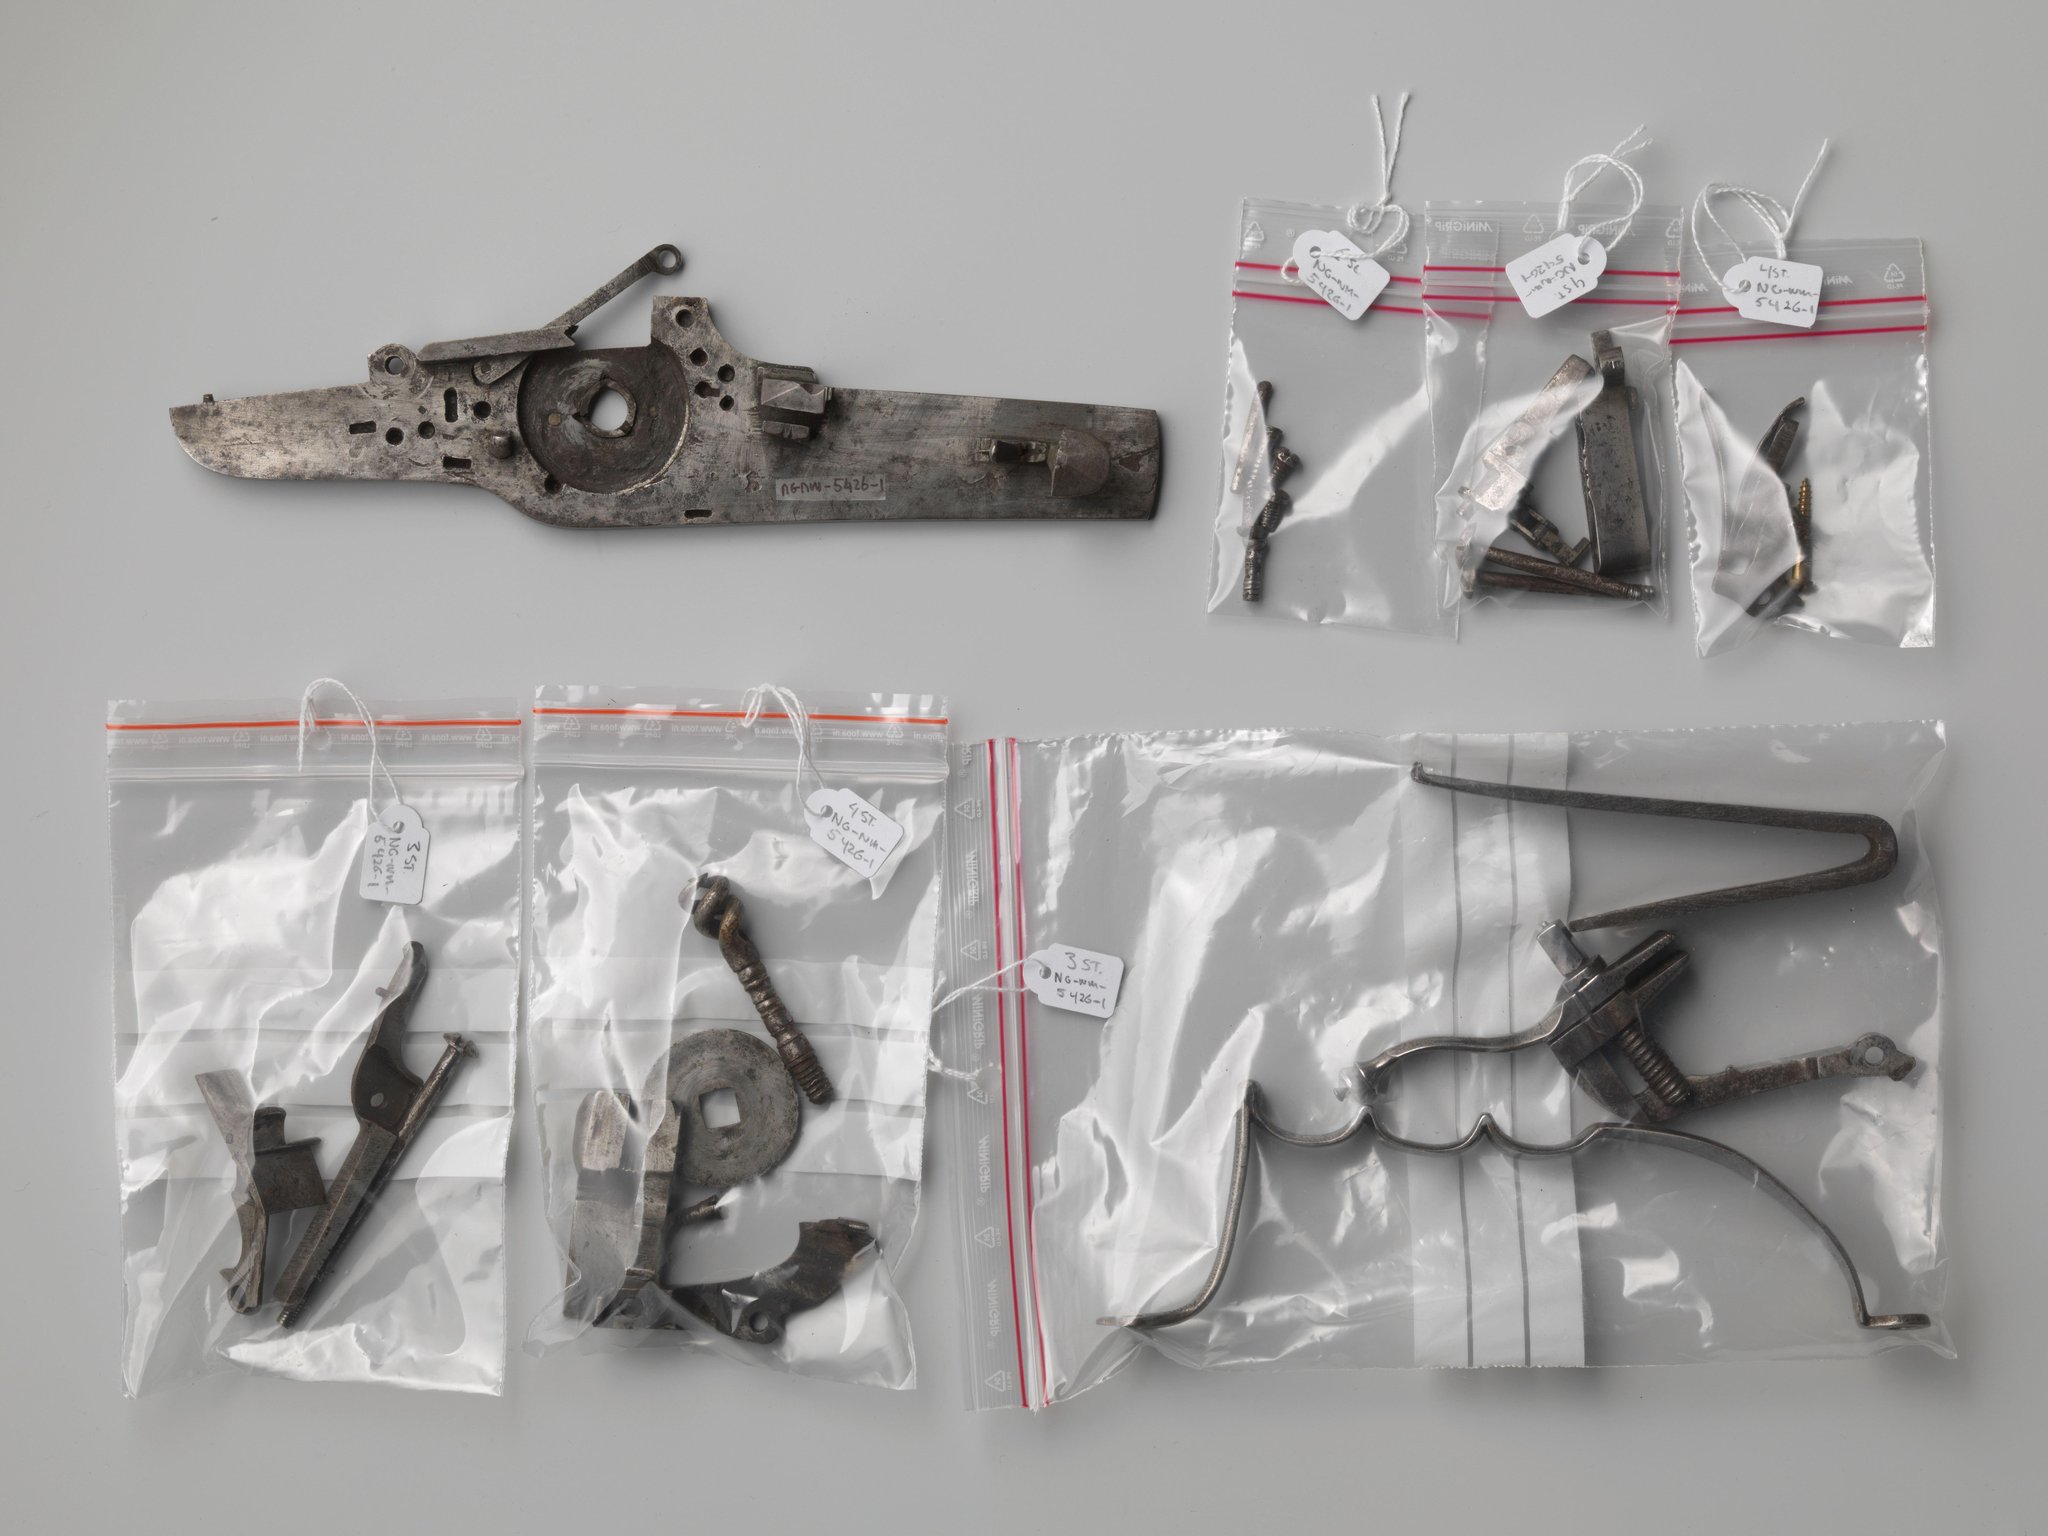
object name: radslotgeweer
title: Onderdelen van een radslotgeweer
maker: Anonymous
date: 1600-1620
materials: copper, iron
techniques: engraving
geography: prague